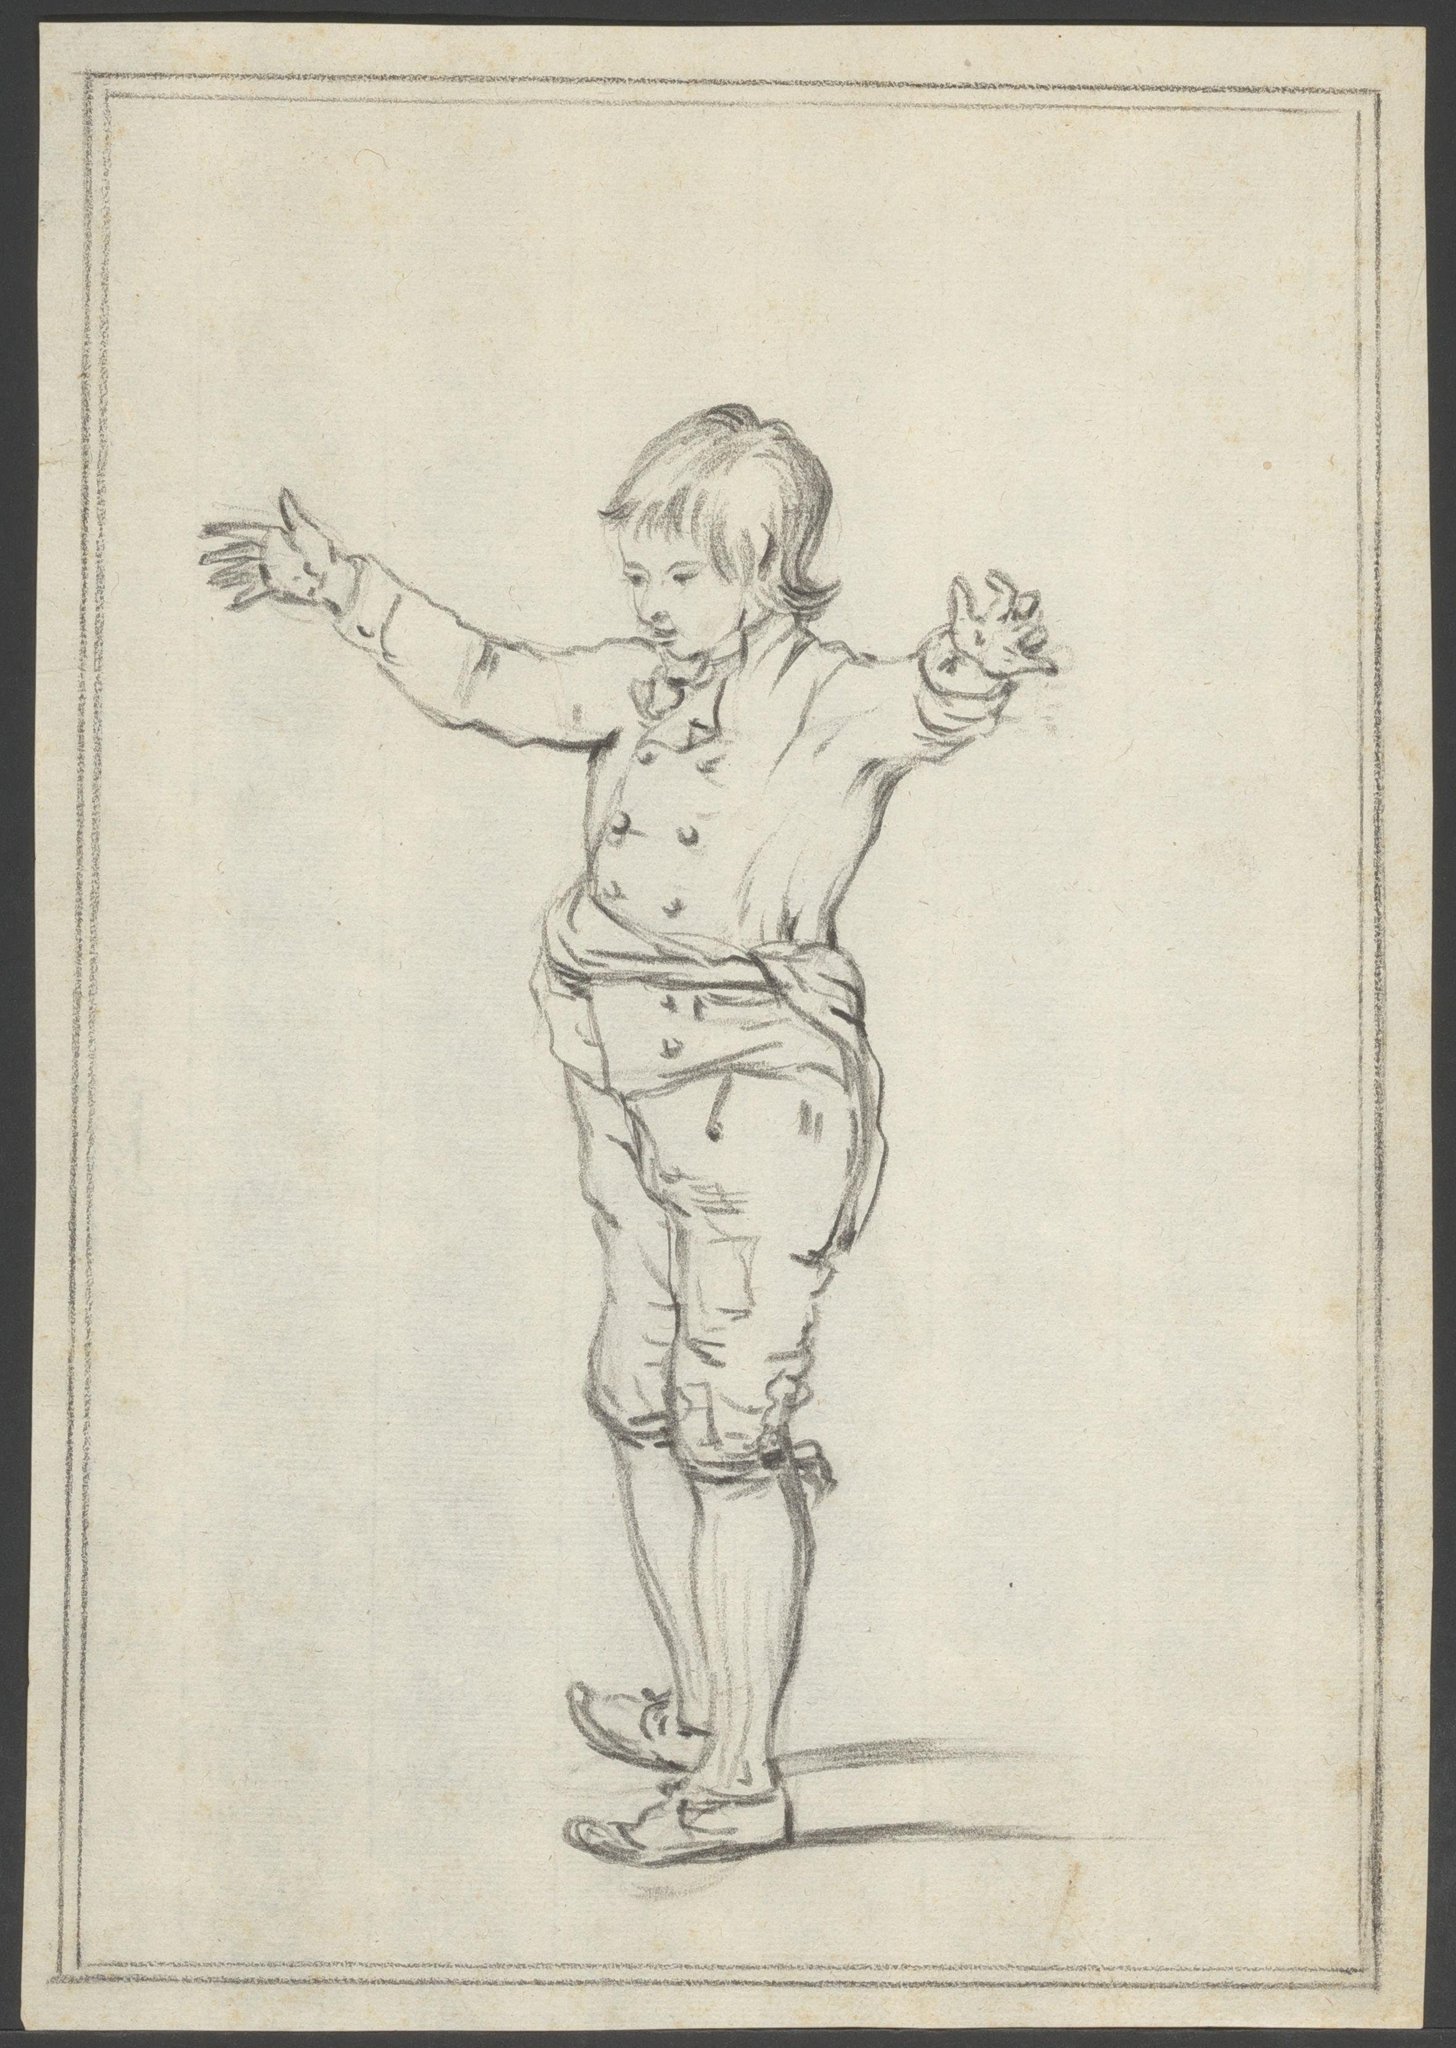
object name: drawing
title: Jong kind met gespreide armen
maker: Anonymous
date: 1800-1899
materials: chalk, paper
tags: boy (child between toddler and youth), arm raised, with fingers spread out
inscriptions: collector's mark: Lugt 1641, stamp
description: Onderwerpsrubrieken binnen de Atlas Zeden en Gewoonten: Schoone kunsten, Schilderkunst, Tekeningen.